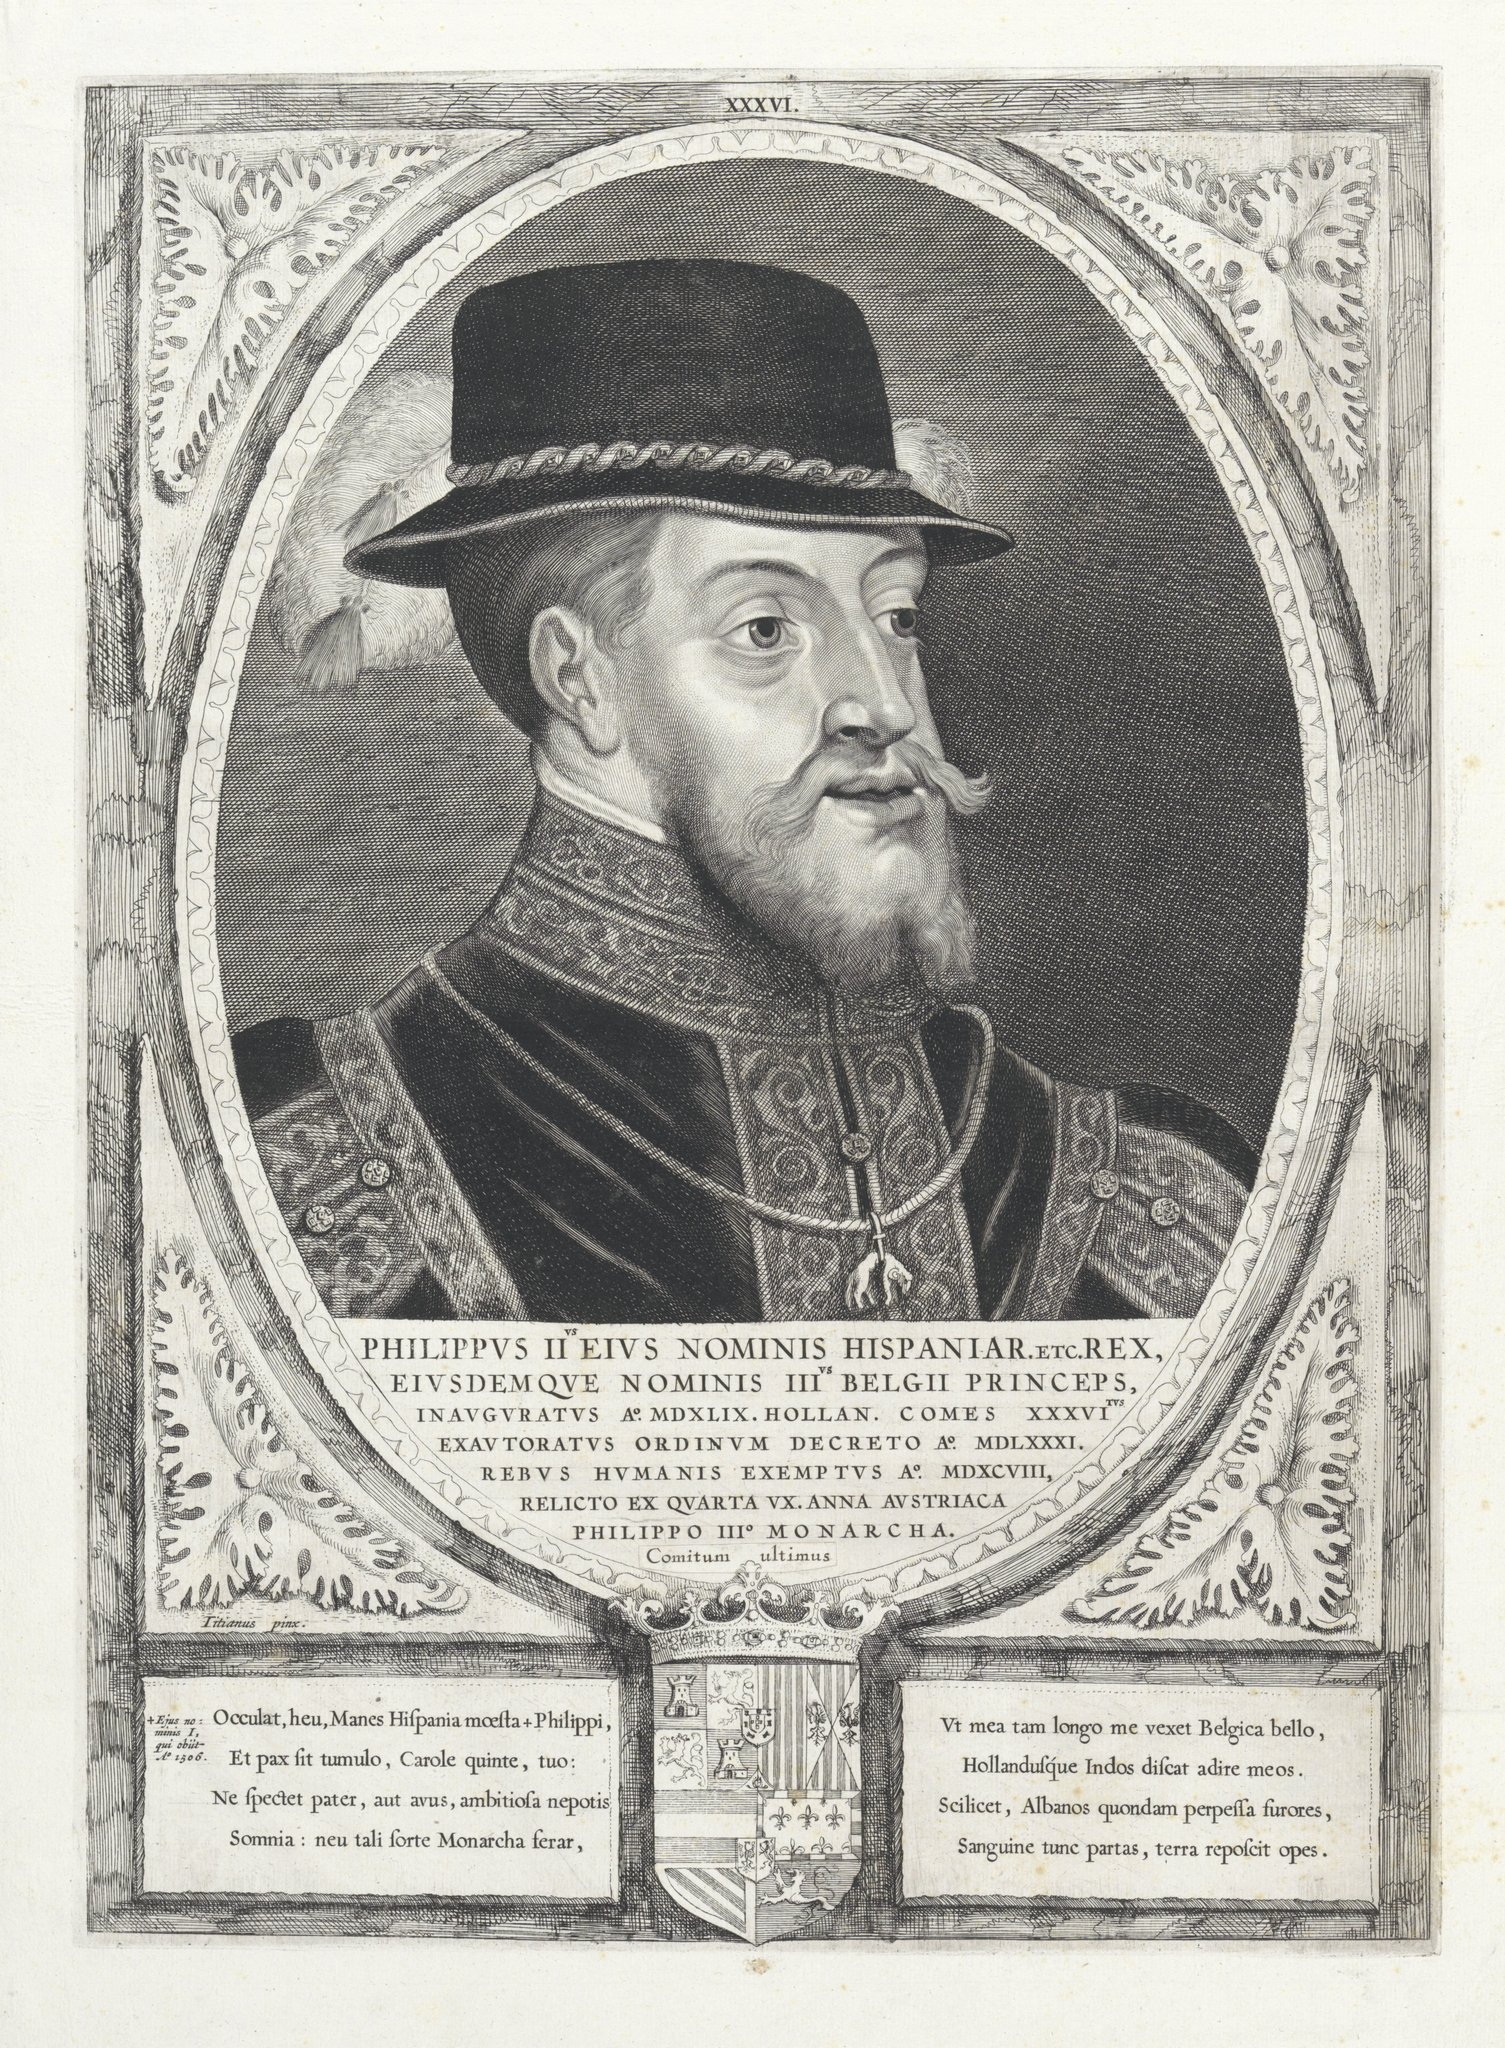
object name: print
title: Portret van Filips II, koning van Spanje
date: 1650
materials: paper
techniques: engraving, etching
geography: haarlem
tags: philip ii of spain, head-gear: hat (+ men's clothes), knighthood order of the golden fleece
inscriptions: collector's mark: Lugt 12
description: Proefdruk van de zesendertigeste prent uit de serie 'Graven en gravinnen van Holland, Zeeland en West-Friesland', bestaande uit 38 prenten.